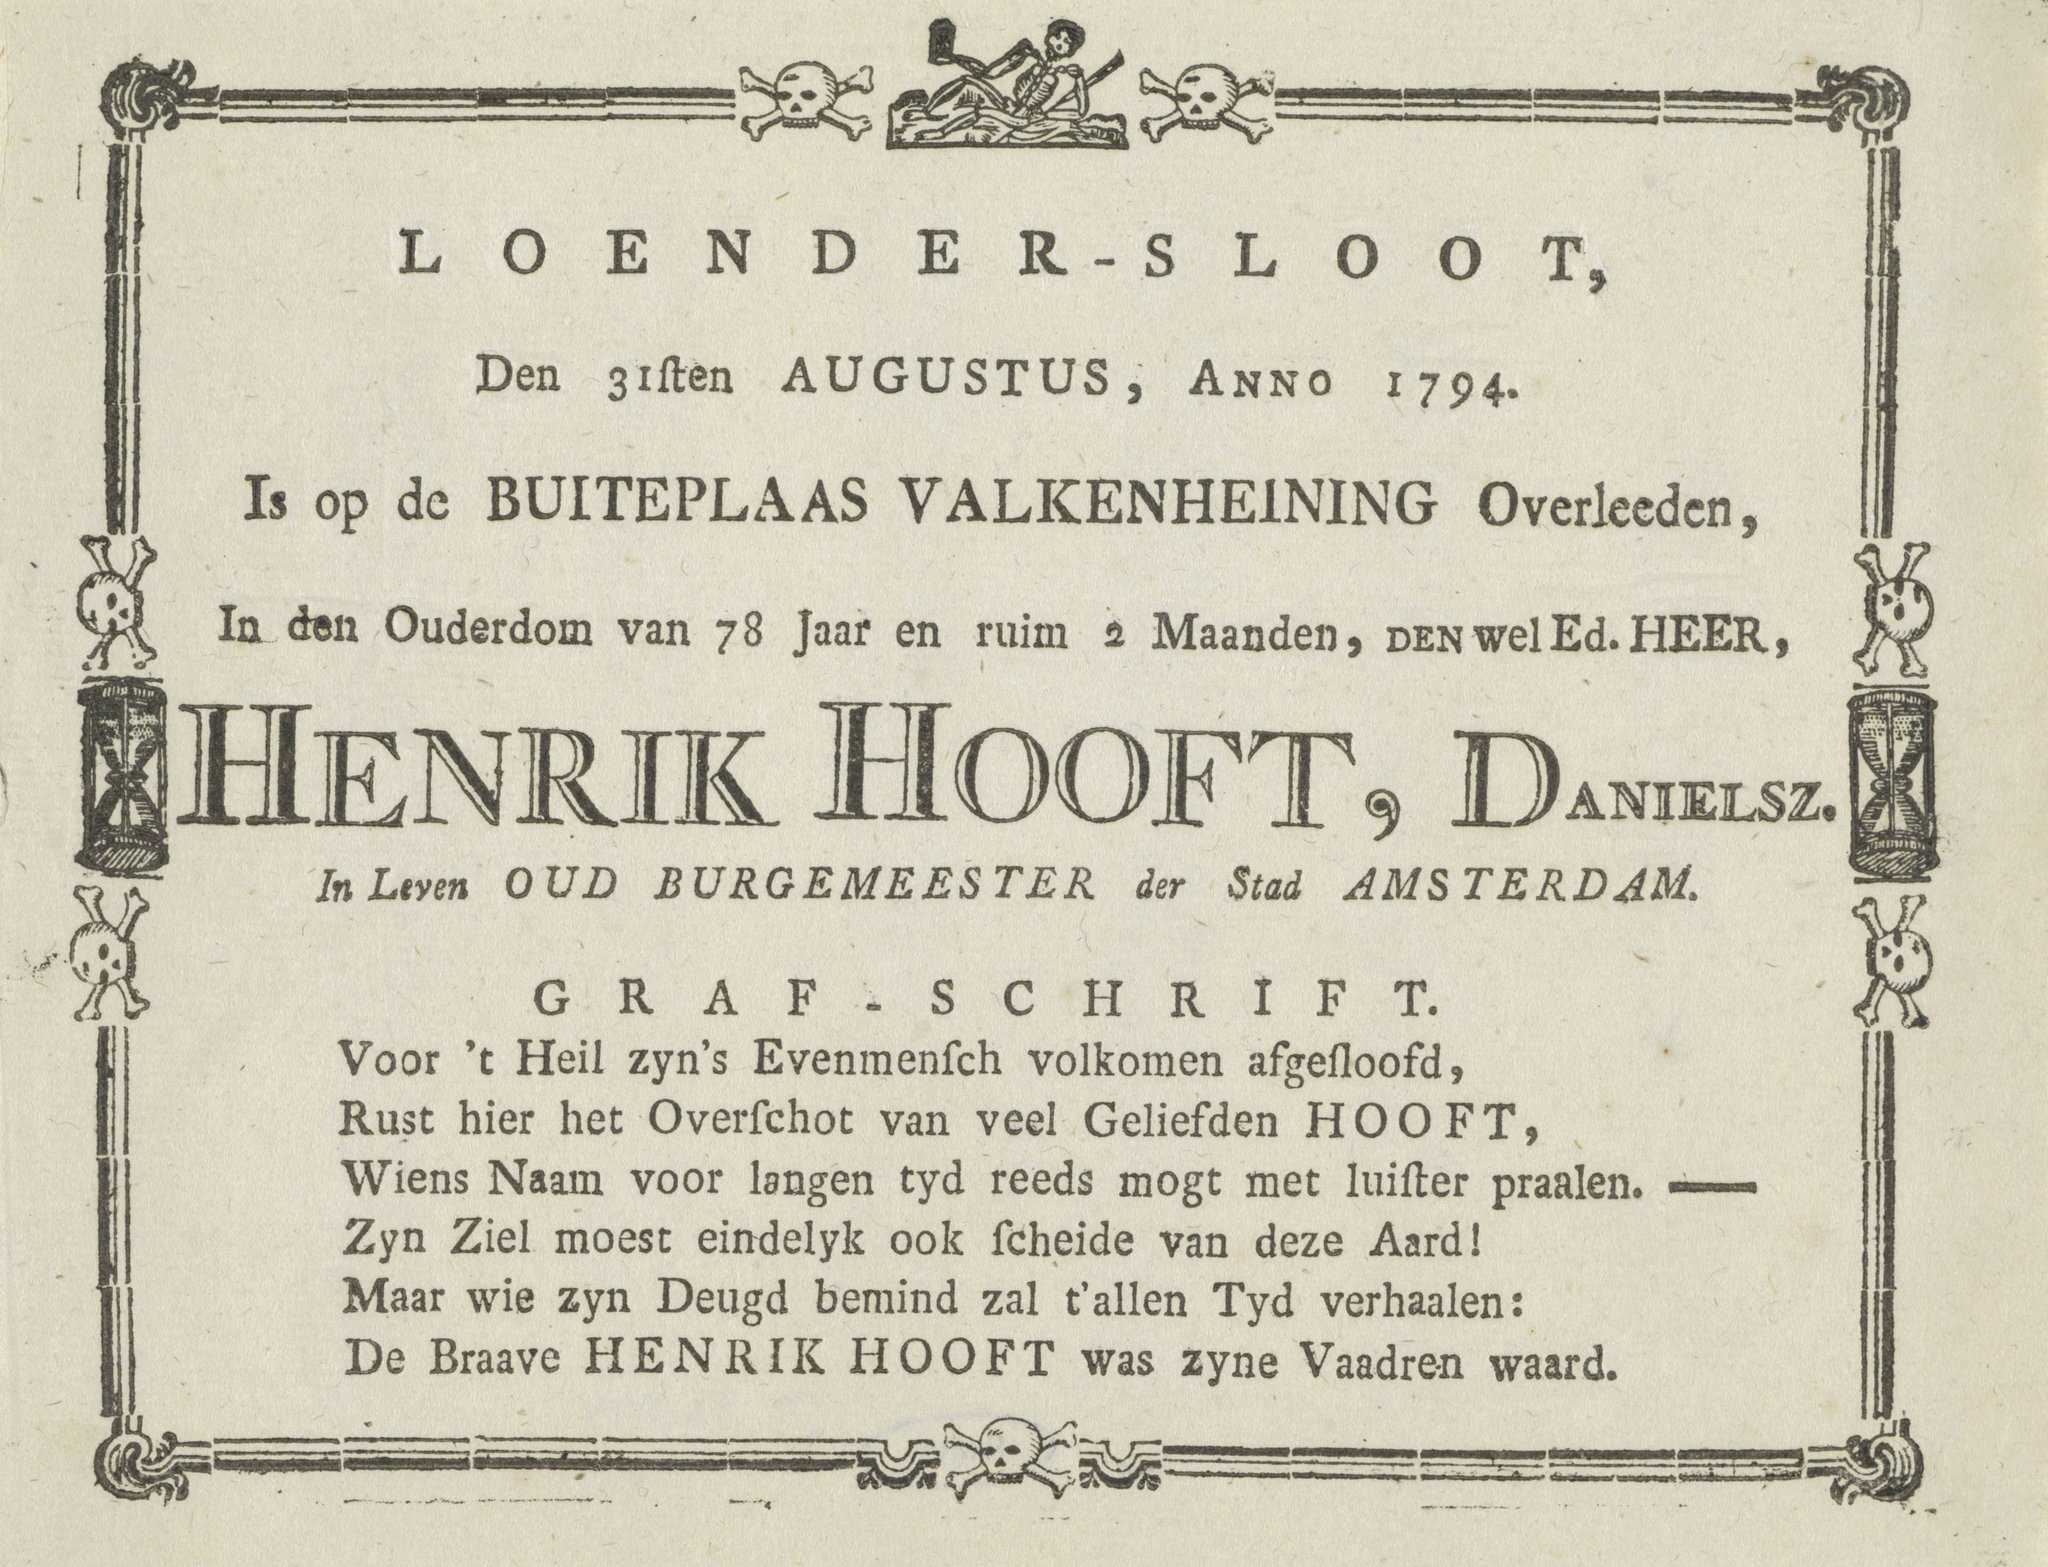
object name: text sheet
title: Bekendmaking van het overlijden van Hendrik Danielsz. Hooft, 1794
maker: Anonymous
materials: paper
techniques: letterpress printing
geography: northern netherlands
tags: amsterdam, mayor, hendrik danielsz. hooft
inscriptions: collector's mark: Lugt 2228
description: Bekendmaking van het overlijden van Hendrik Danielsz. Hooft, oud-burgemeester van Amsterdam, op 31 augustus 1794 op de buitenplaats Valkenheining te Loenersloot. Tekst met een zesregelig vers binnen een versierde rand.